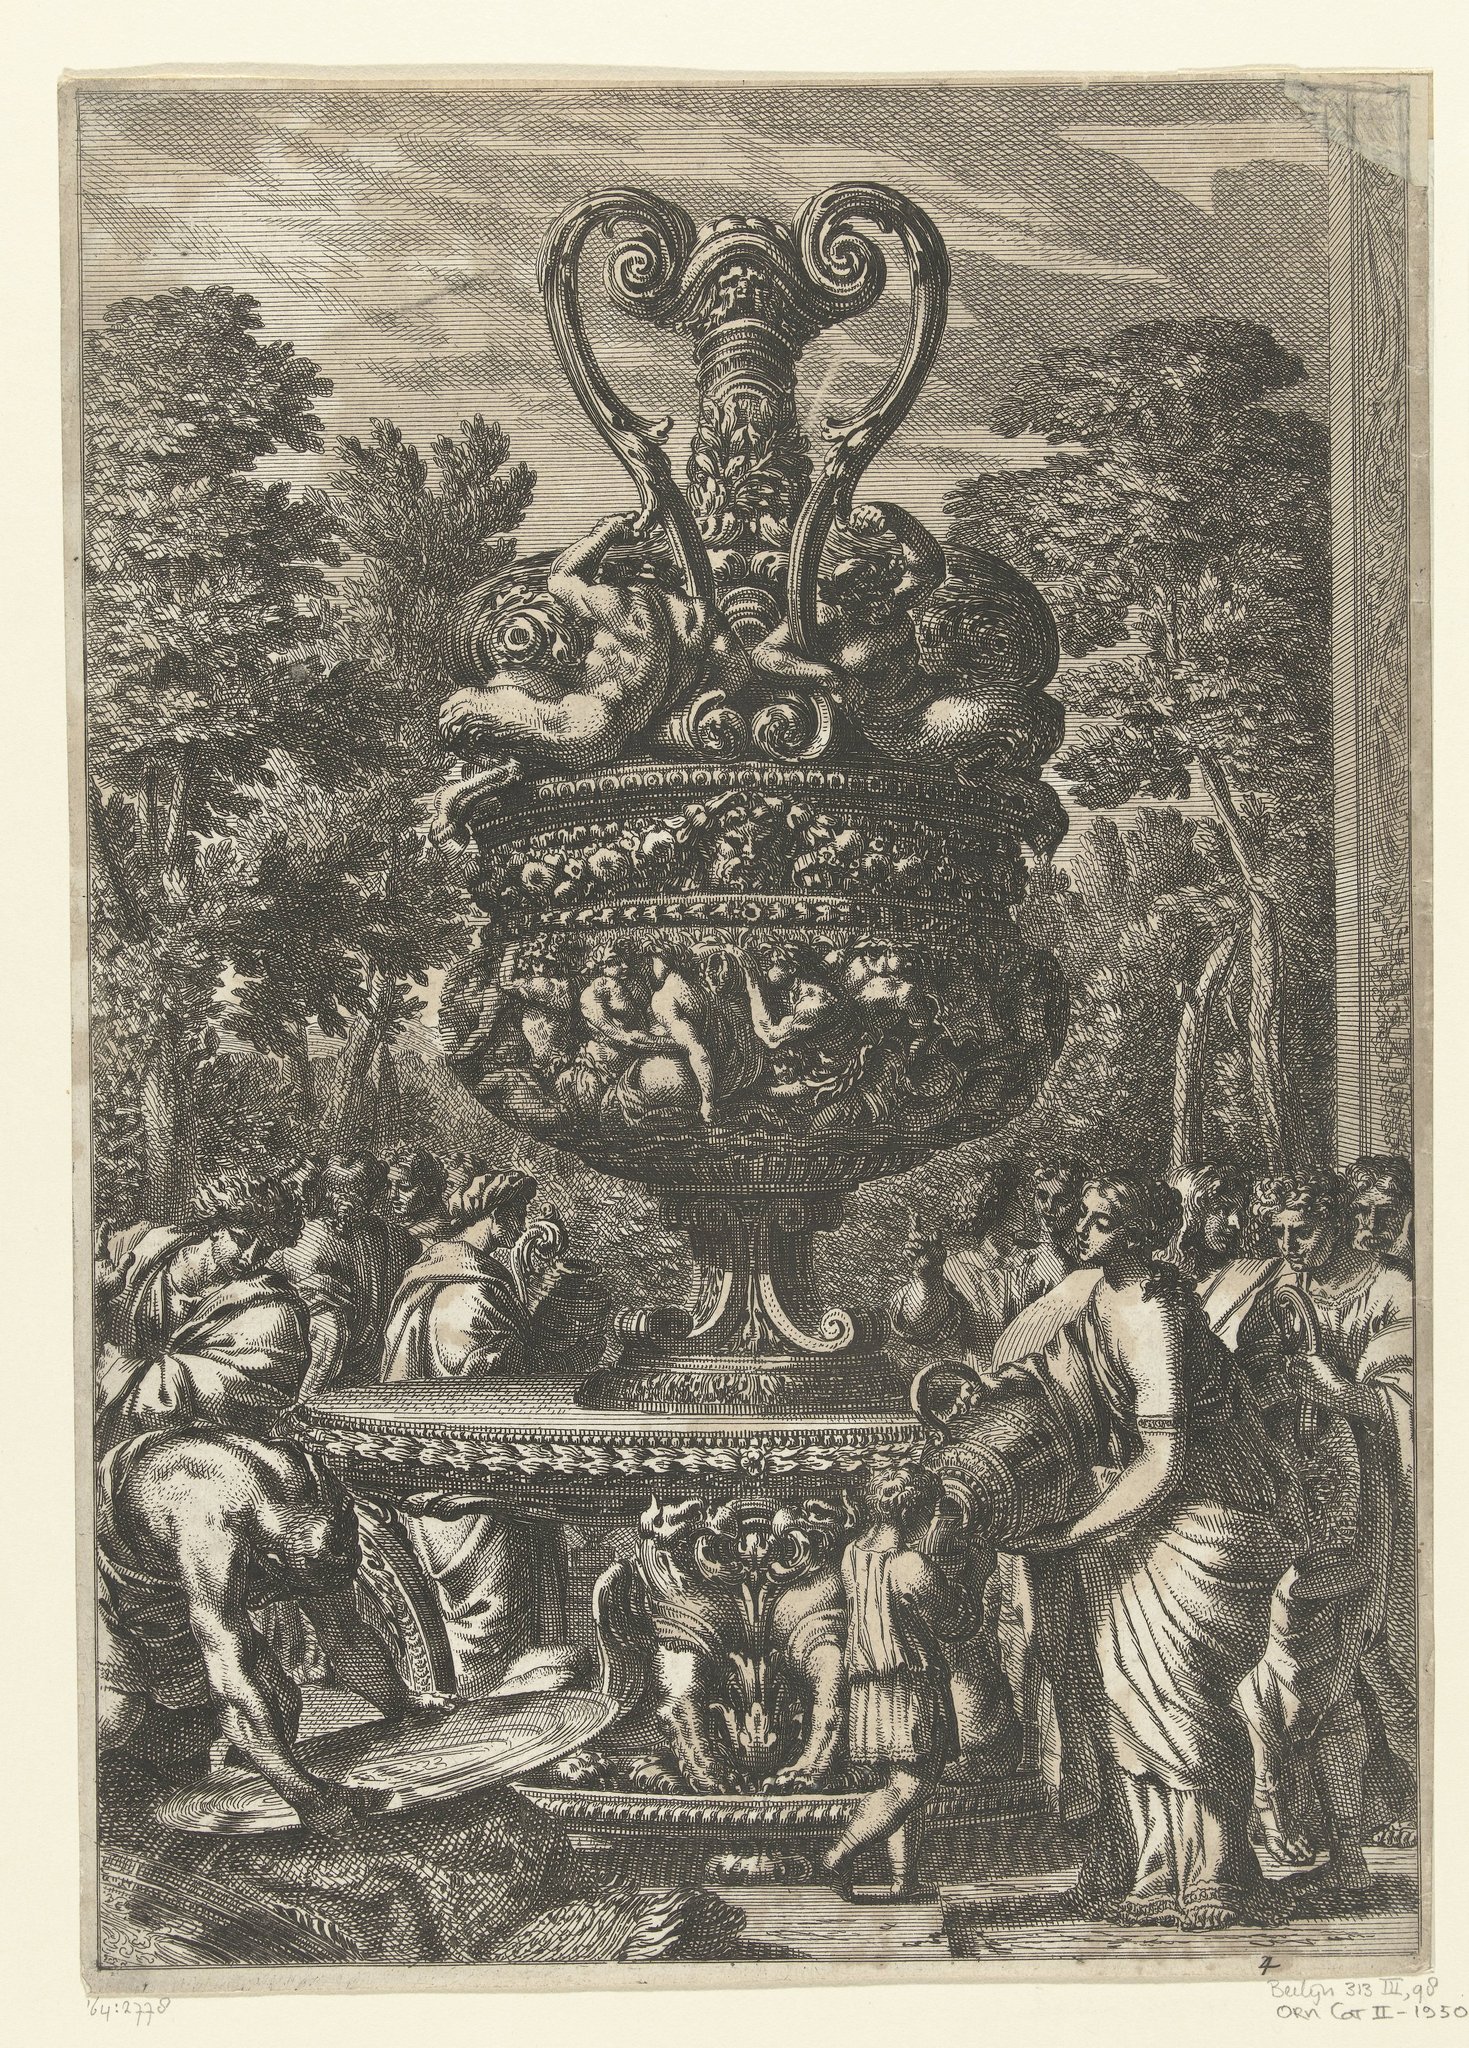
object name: ornament print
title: Schenkkan of vaas op ronde tafel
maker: jean lepautre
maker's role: draughtsman, print maker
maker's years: 1618-1682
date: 1650-1664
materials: paper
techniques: etching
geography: france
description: De tafel wordt ondersteund door griffioenen.